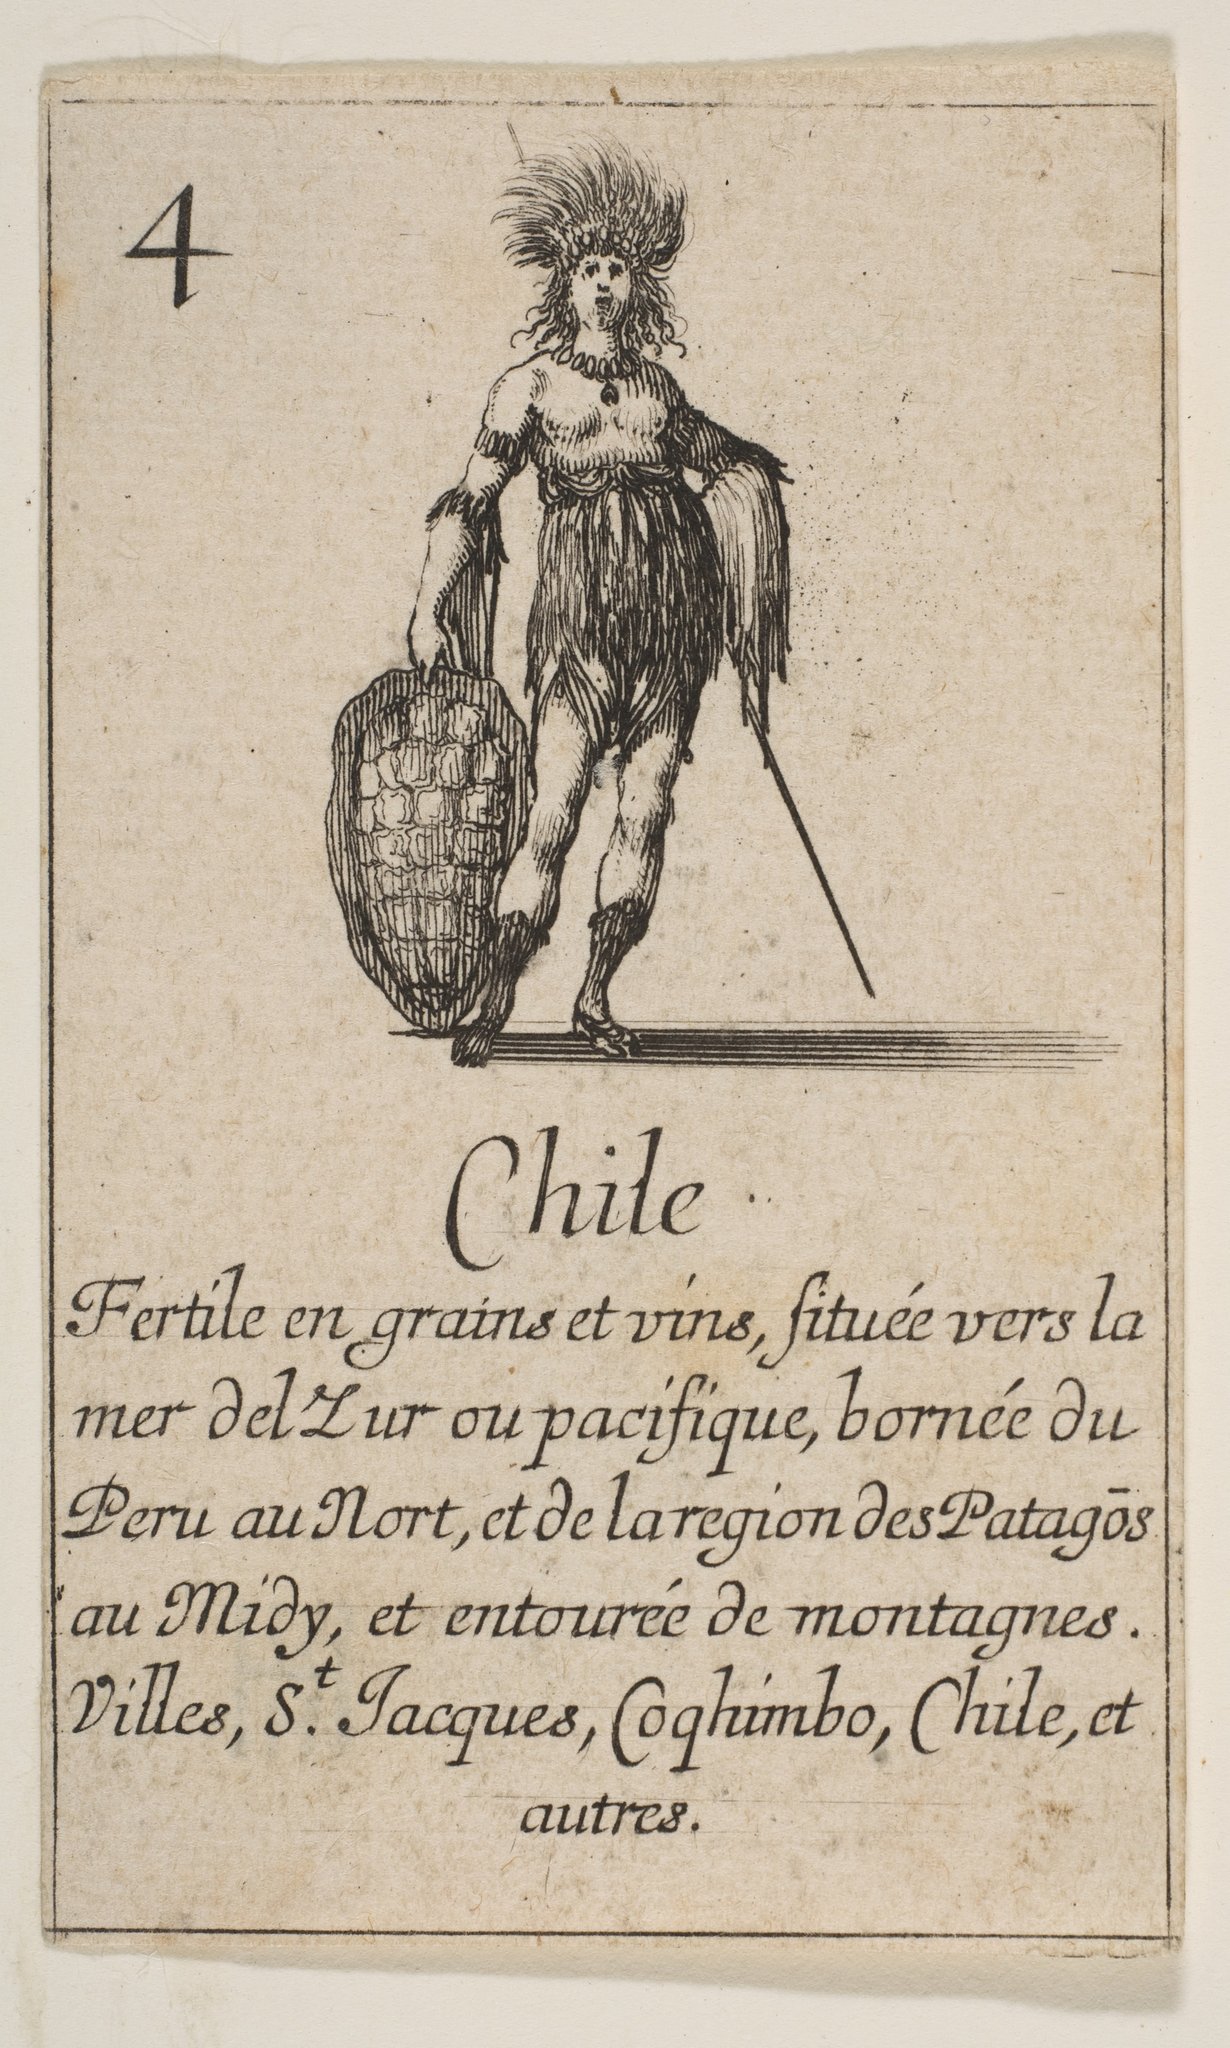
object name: print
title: Chile, from the playing cards "Jeu de la Géographie"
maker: stefano della bella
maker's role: artist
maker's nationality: italian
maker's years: 1610-1664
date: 1644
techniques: etching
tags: shields,swords,men